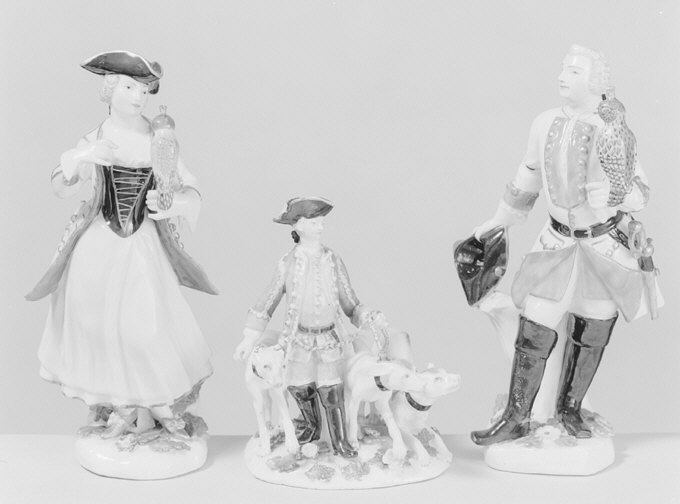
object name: figure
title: Falconer (one of a pair)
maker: meissen manufactory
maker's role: manufactory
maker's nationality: german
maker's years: 1710-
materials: hard paste porcelain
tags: birds,men,women,dogs